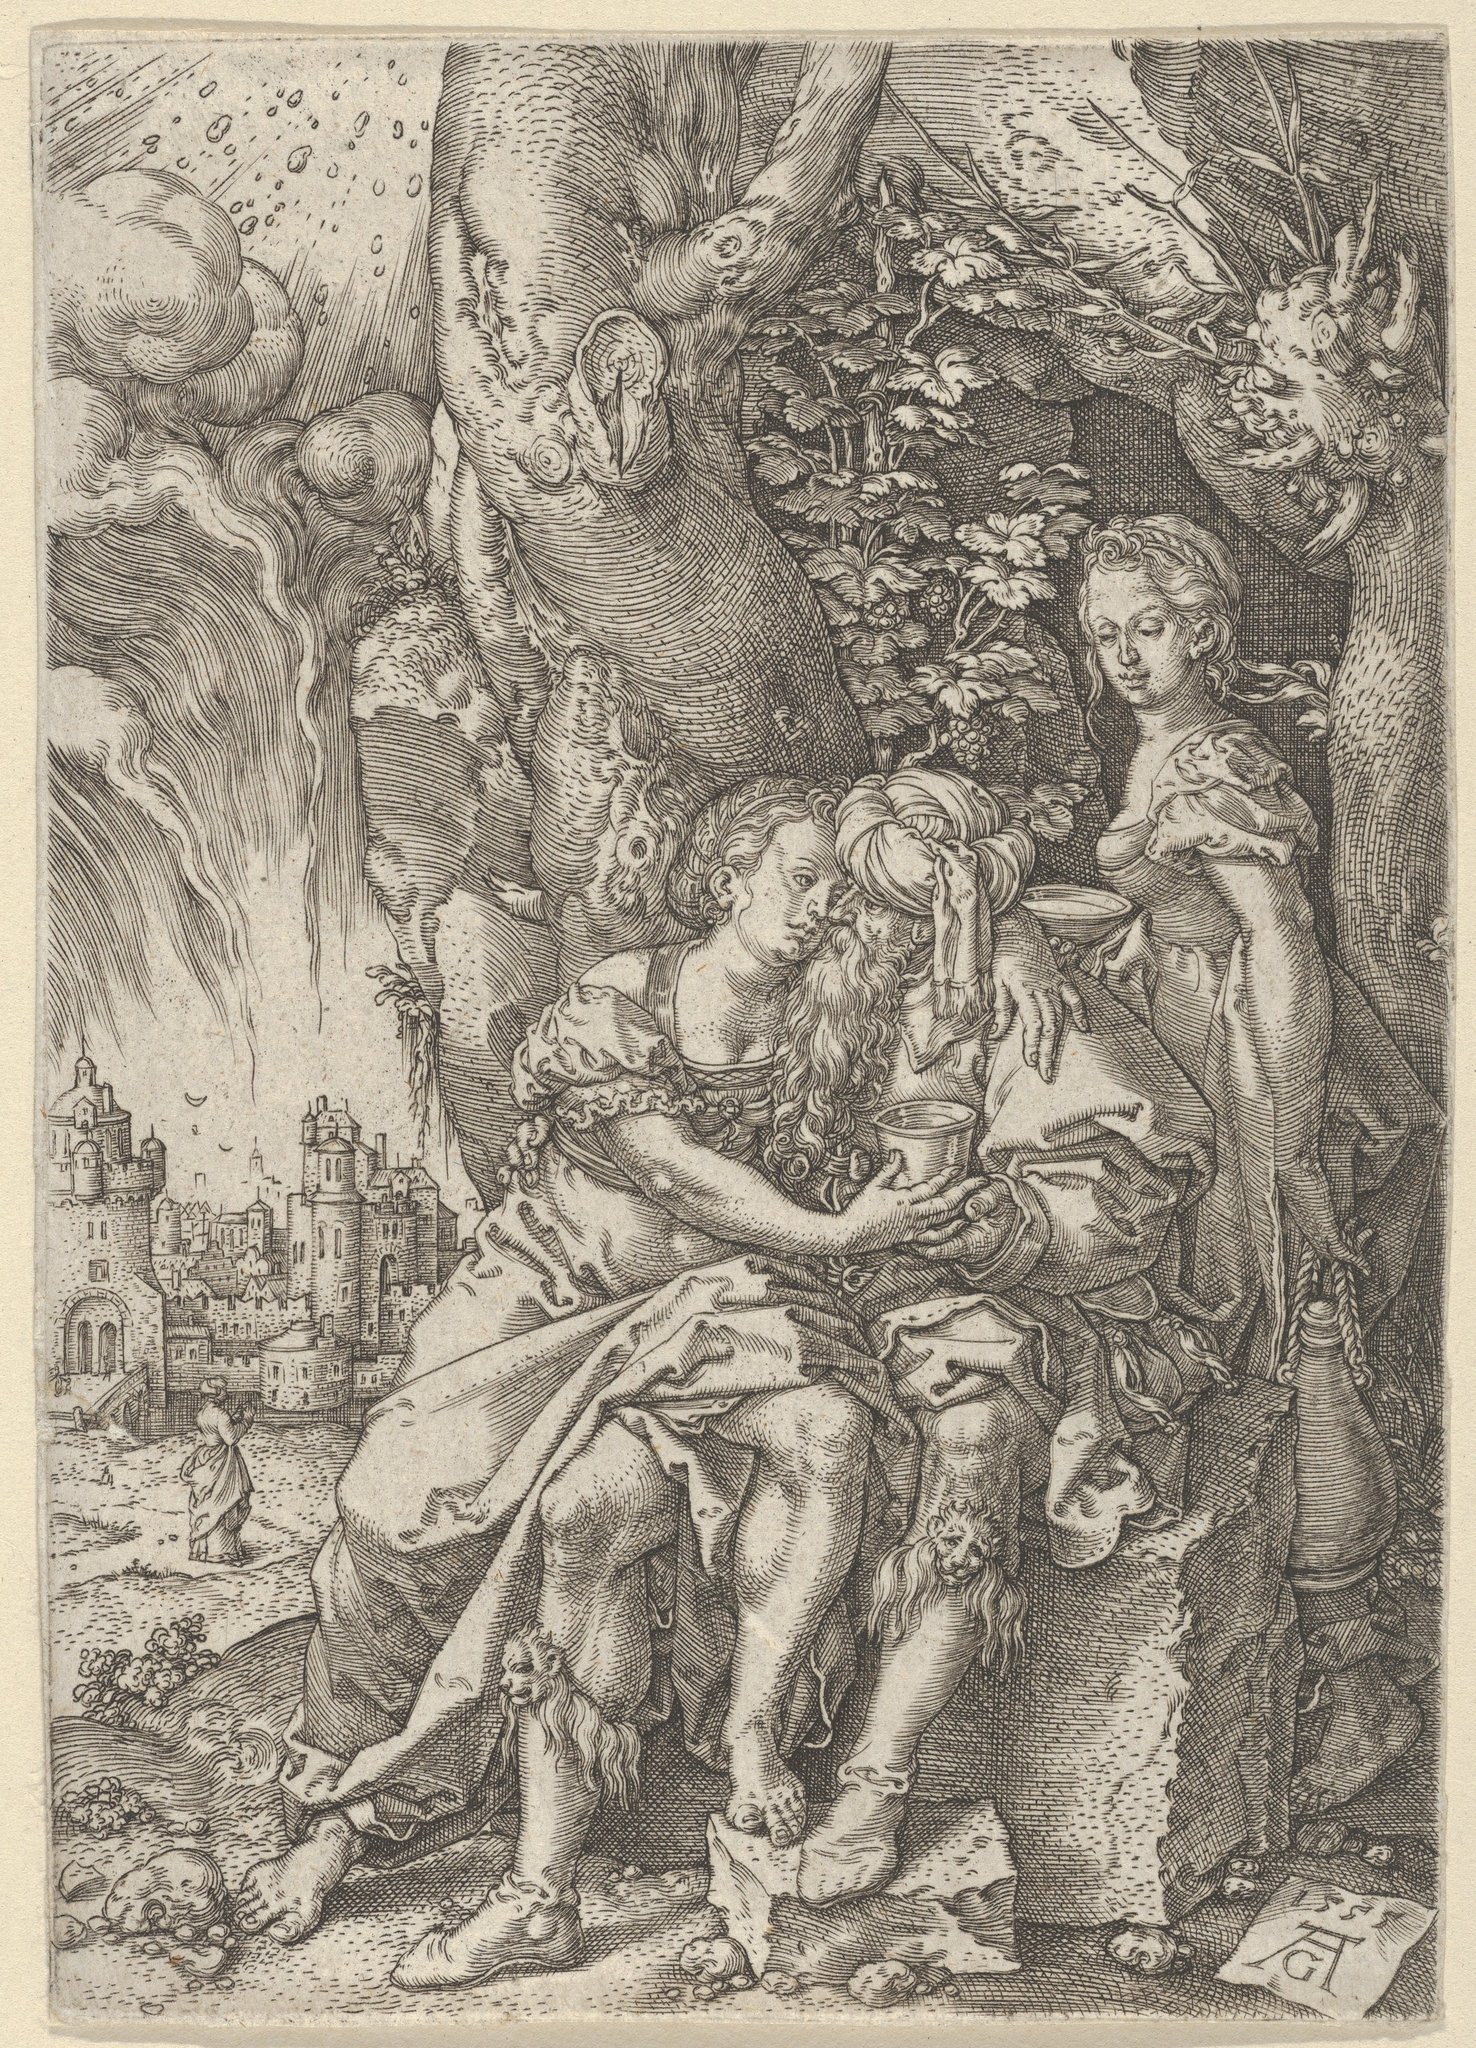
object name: print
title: Lot with His Daughters, from The Story of Lot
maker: heinrich aldegrever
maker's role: artist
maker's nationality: german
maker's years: 1502-1561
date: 1555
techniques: engraving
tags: men,women,trees